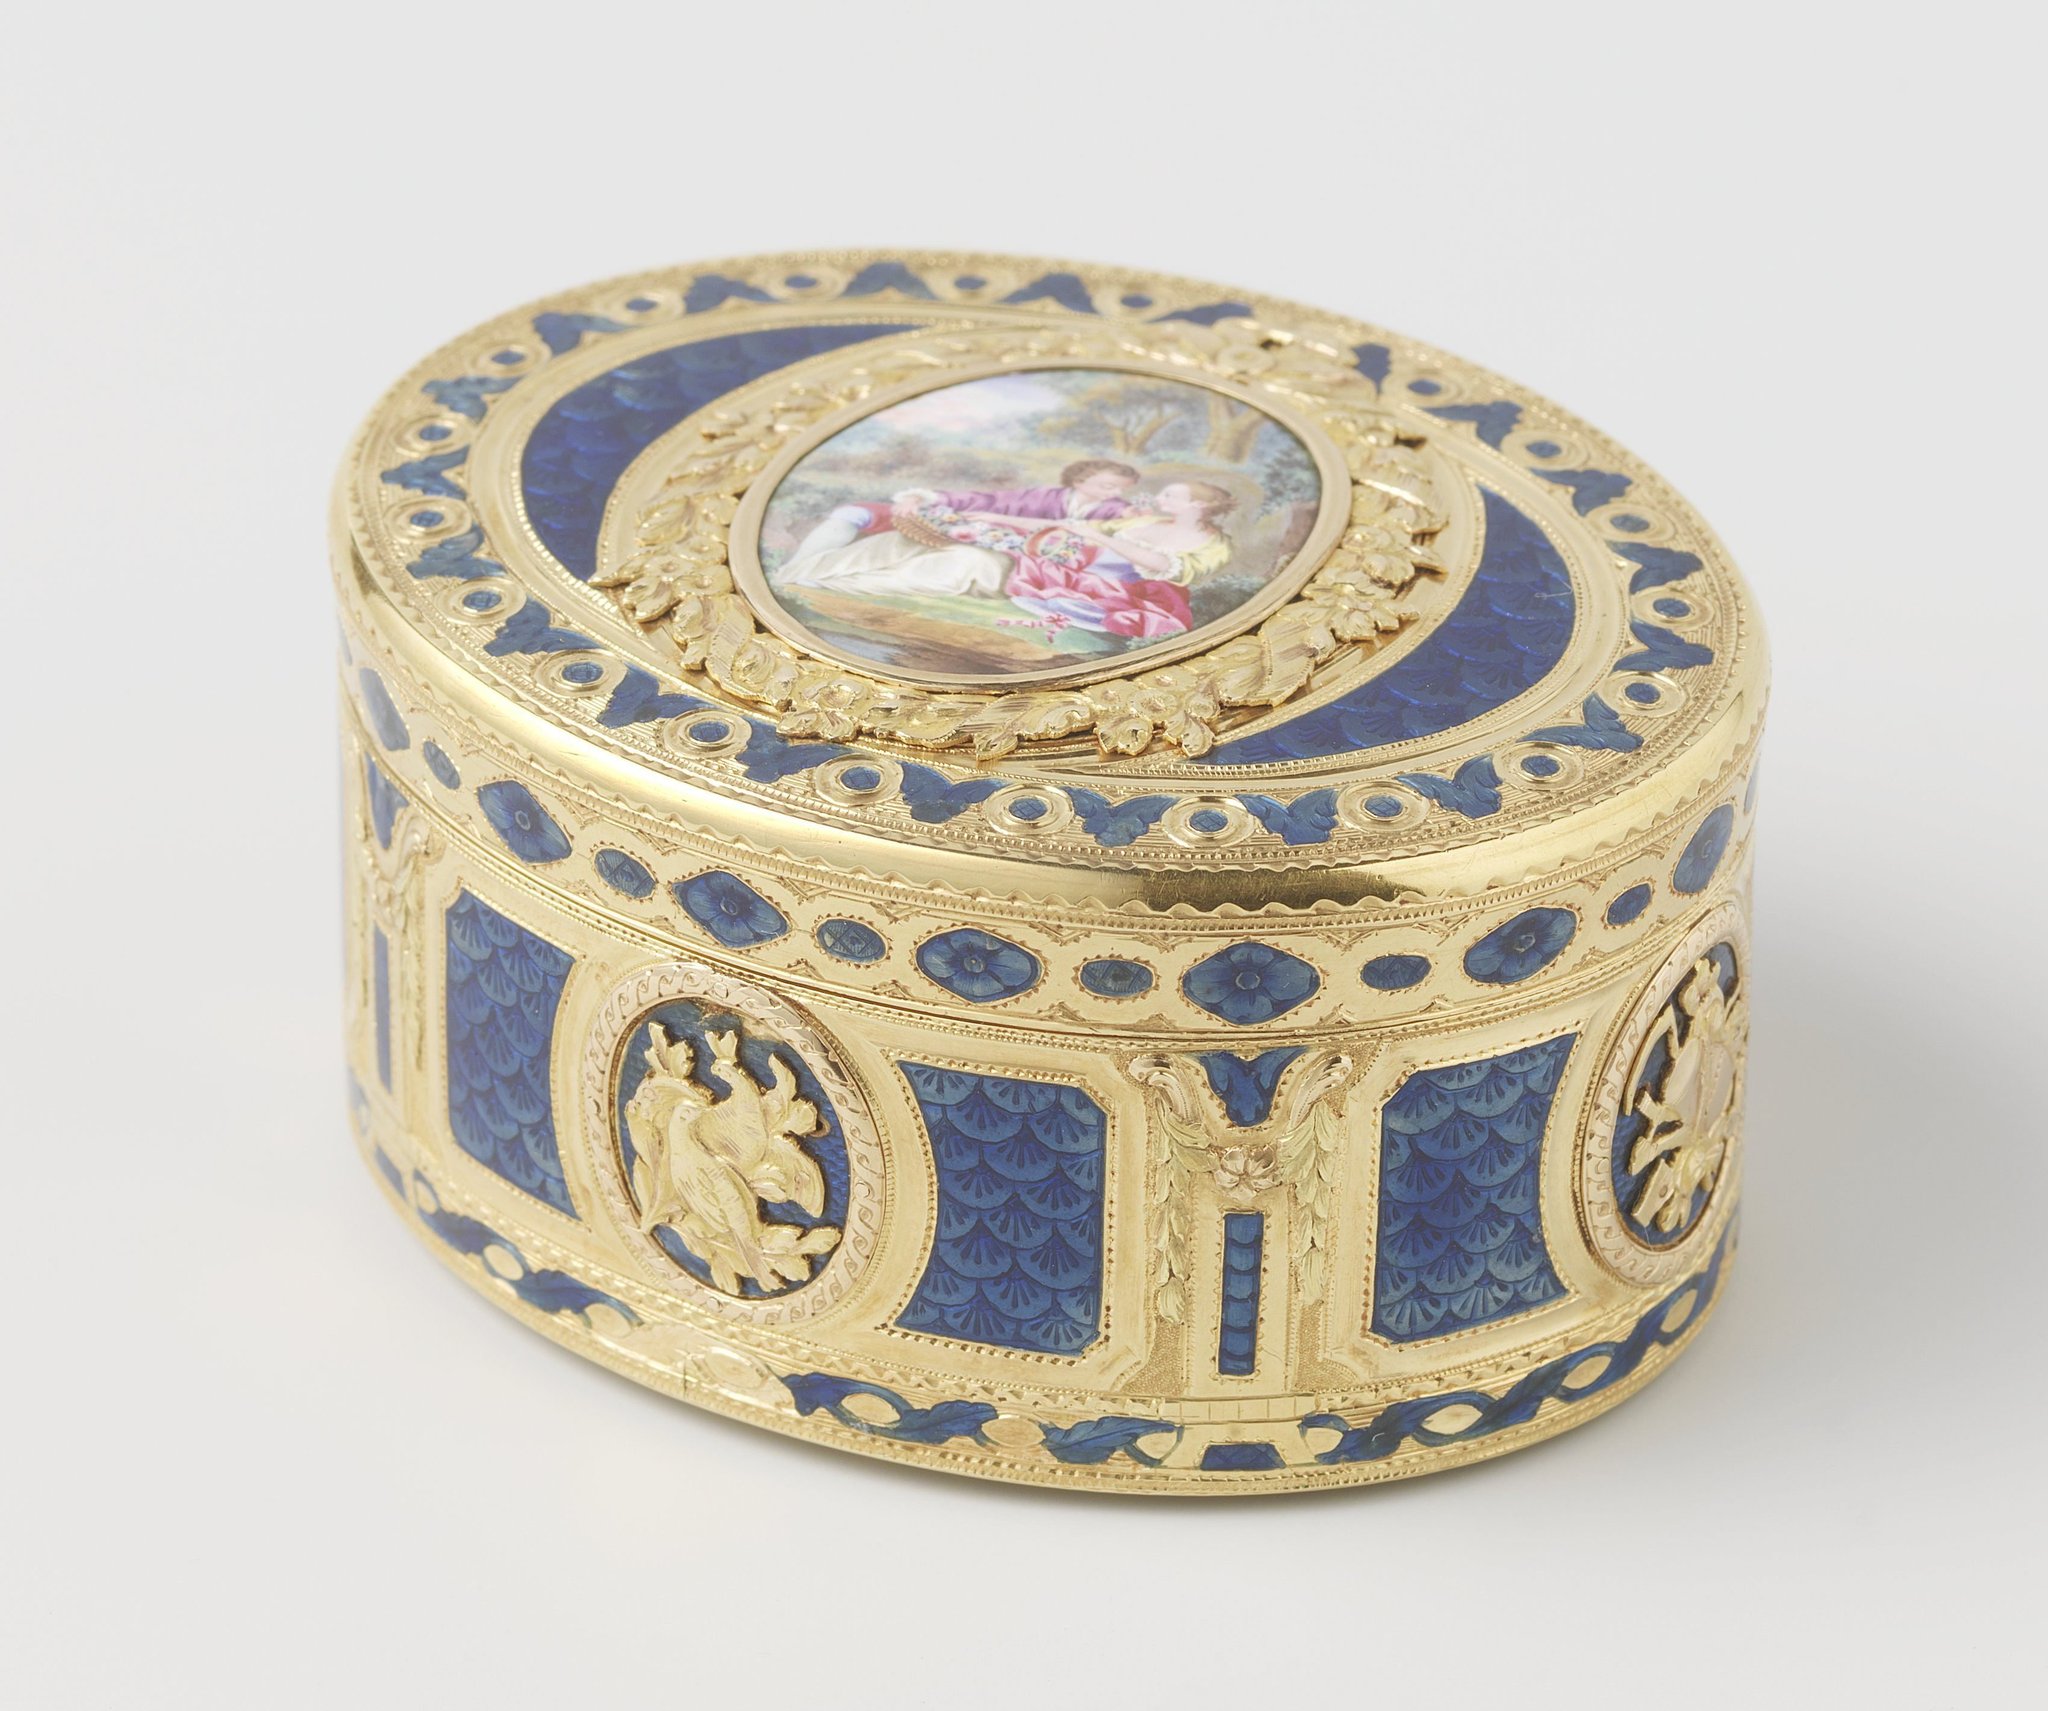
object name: snuffbox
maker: vincent bréant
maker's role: goldsmith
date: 1767-1768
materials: gold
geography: paris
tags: couple of lovers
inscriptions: silver mark, duty mark, countermark, date letter, maker's mark, inscription: ‘779’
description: Snuifdoos van goud, ovaal, met op het deksel een liefdespaar in email. Rondom de wand in blauw email, opgelegde gouden reliëfs met trofeeën en vogels.